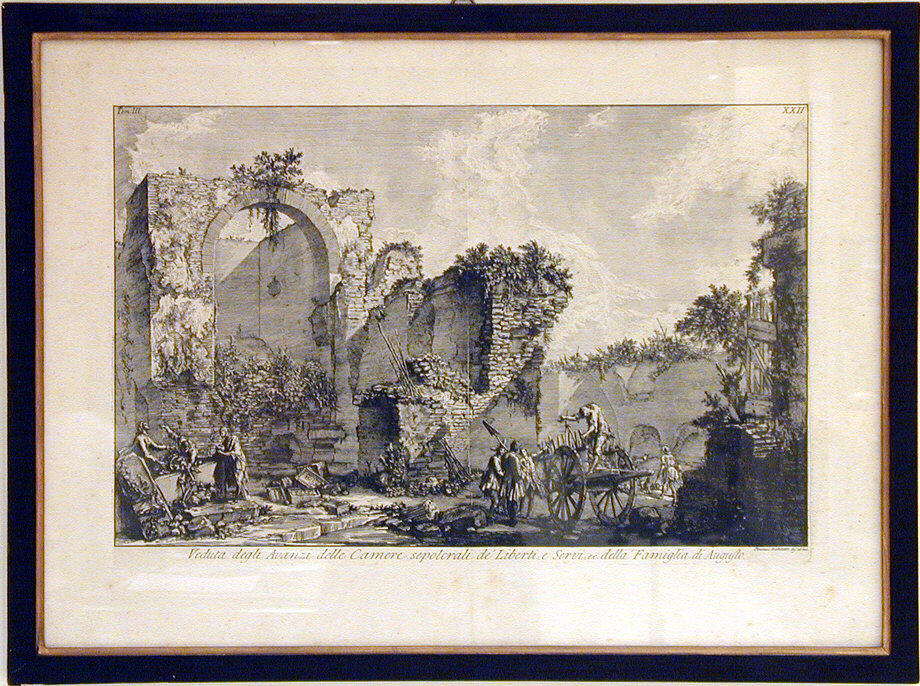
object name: engraving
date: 1701-1800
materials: ink, paper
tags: ruins,maps